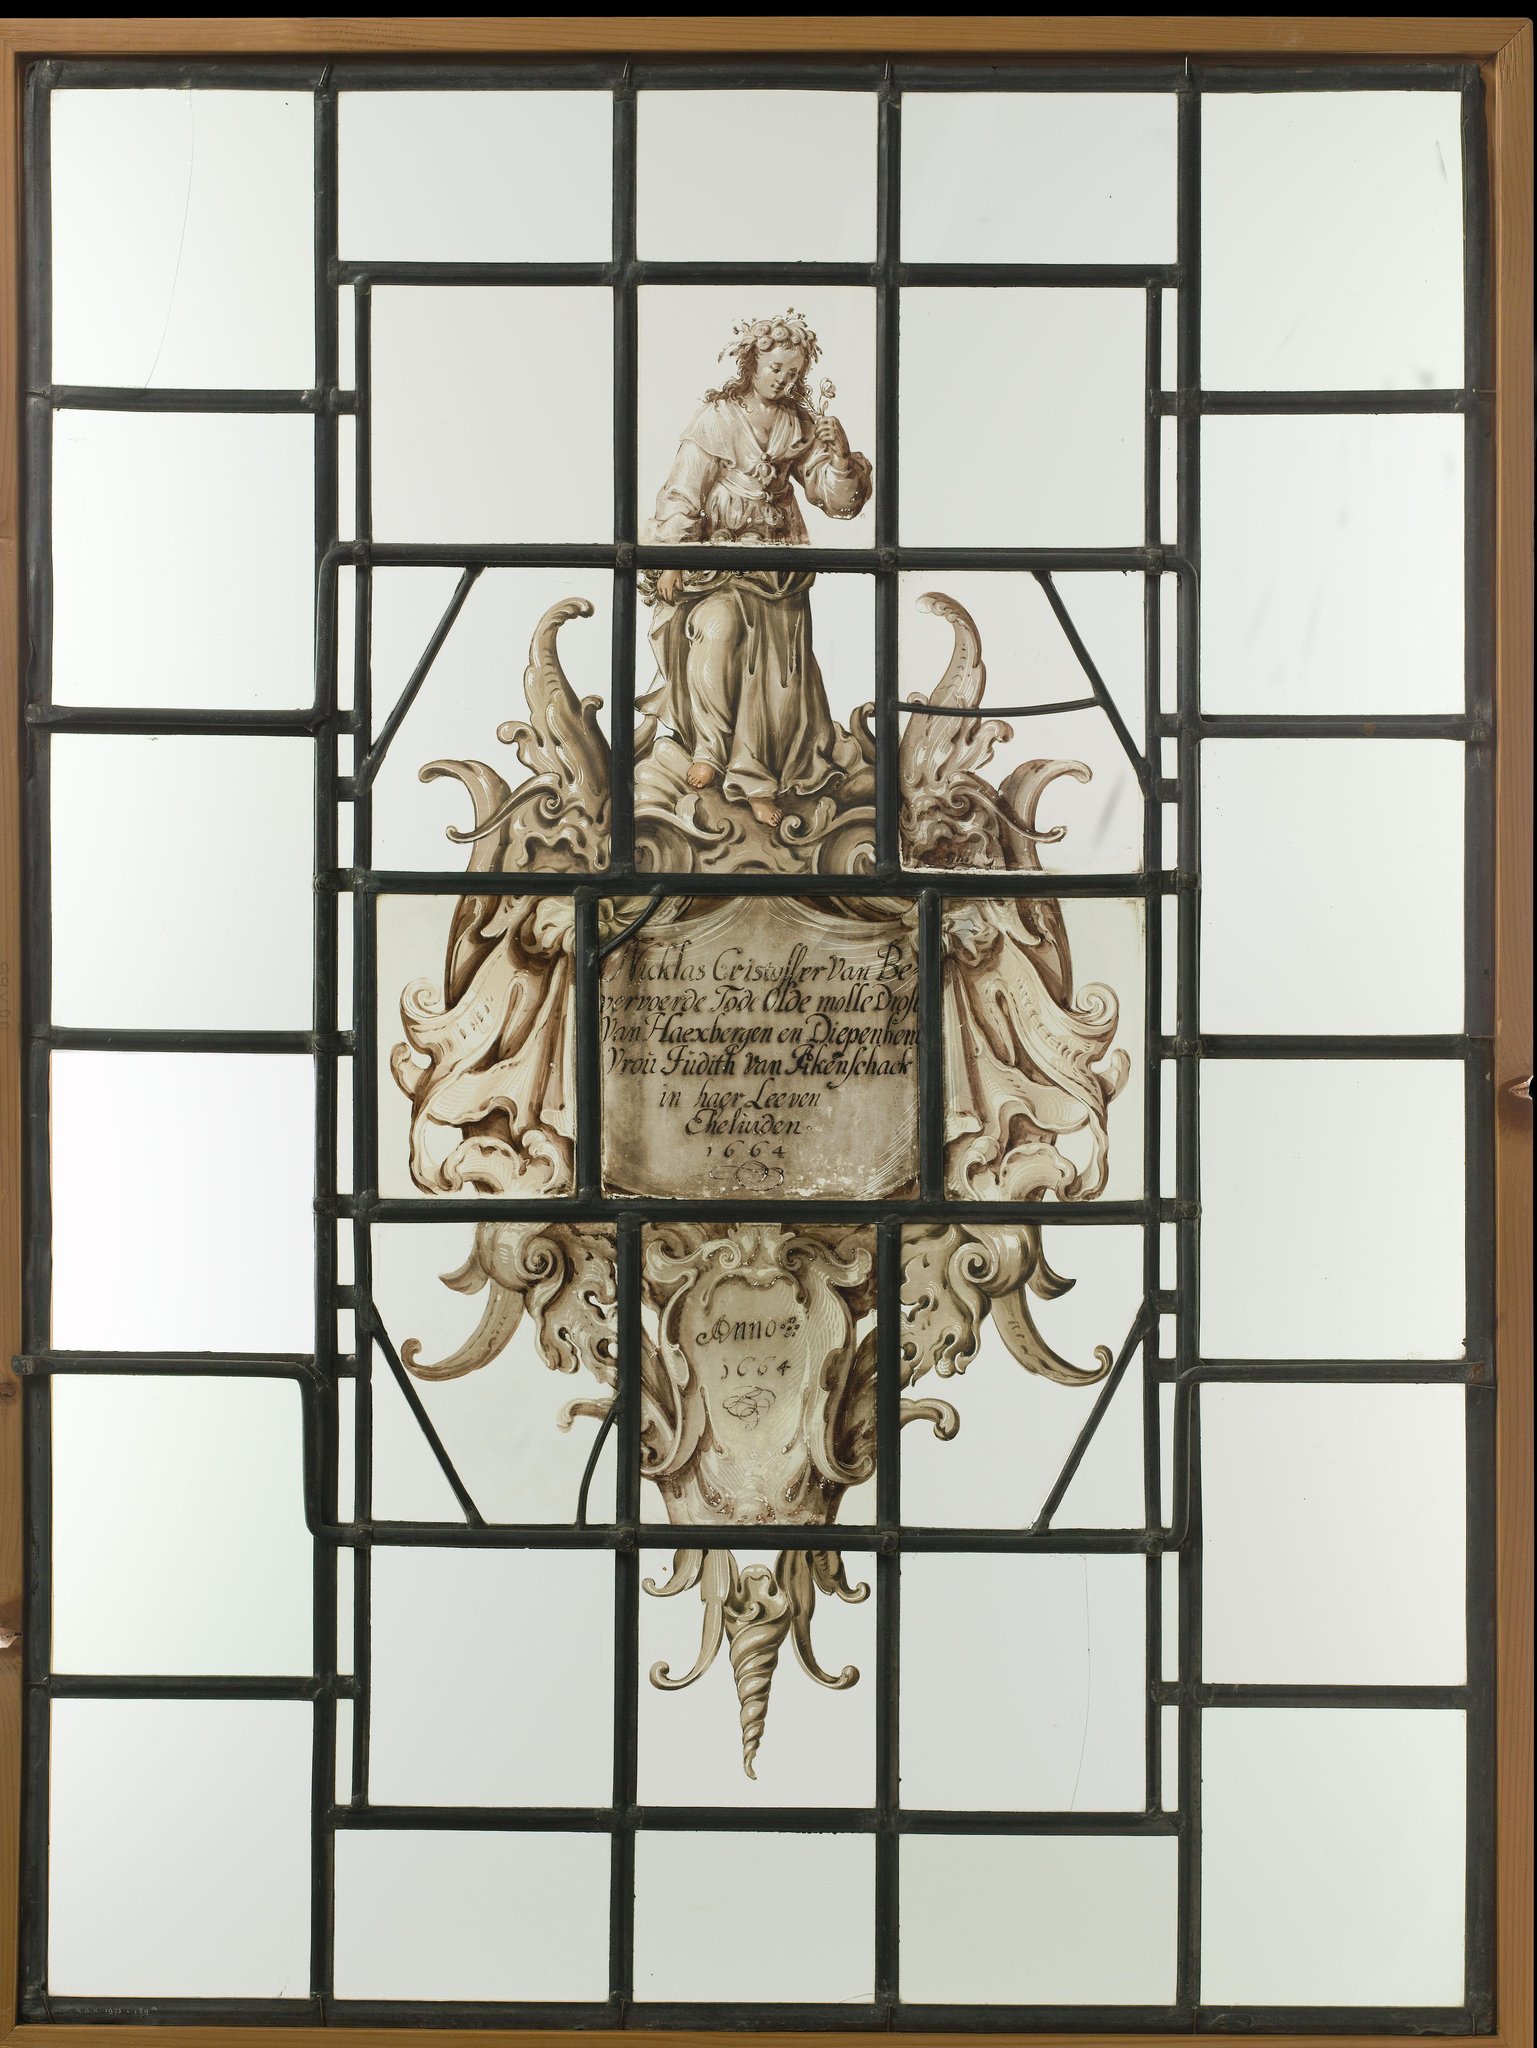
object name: light window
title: Ruit met in cartouche in kwabstijl een wapen met opschrift "Nicklas Cristoffer van Bevervoerde........Drost van Haexbergen en Diepenhem 1664"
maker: Anonymous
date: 1664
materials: glass, lead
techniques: leading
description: Gebrandschilderde ruit in grisaille en vleeskleur met cartouche in kwabstijl waarboven een vrouwenfiguur. In cartouche een familiewapen met tekst: Nicklas Cristoffer van Bevervoerde Tode Olde molle Drost van Haexbergen en Diepenhem Vrou Judith van Akenschack in haar Leeven Eheluiden 1664; daaronder nog eens Anno 1664